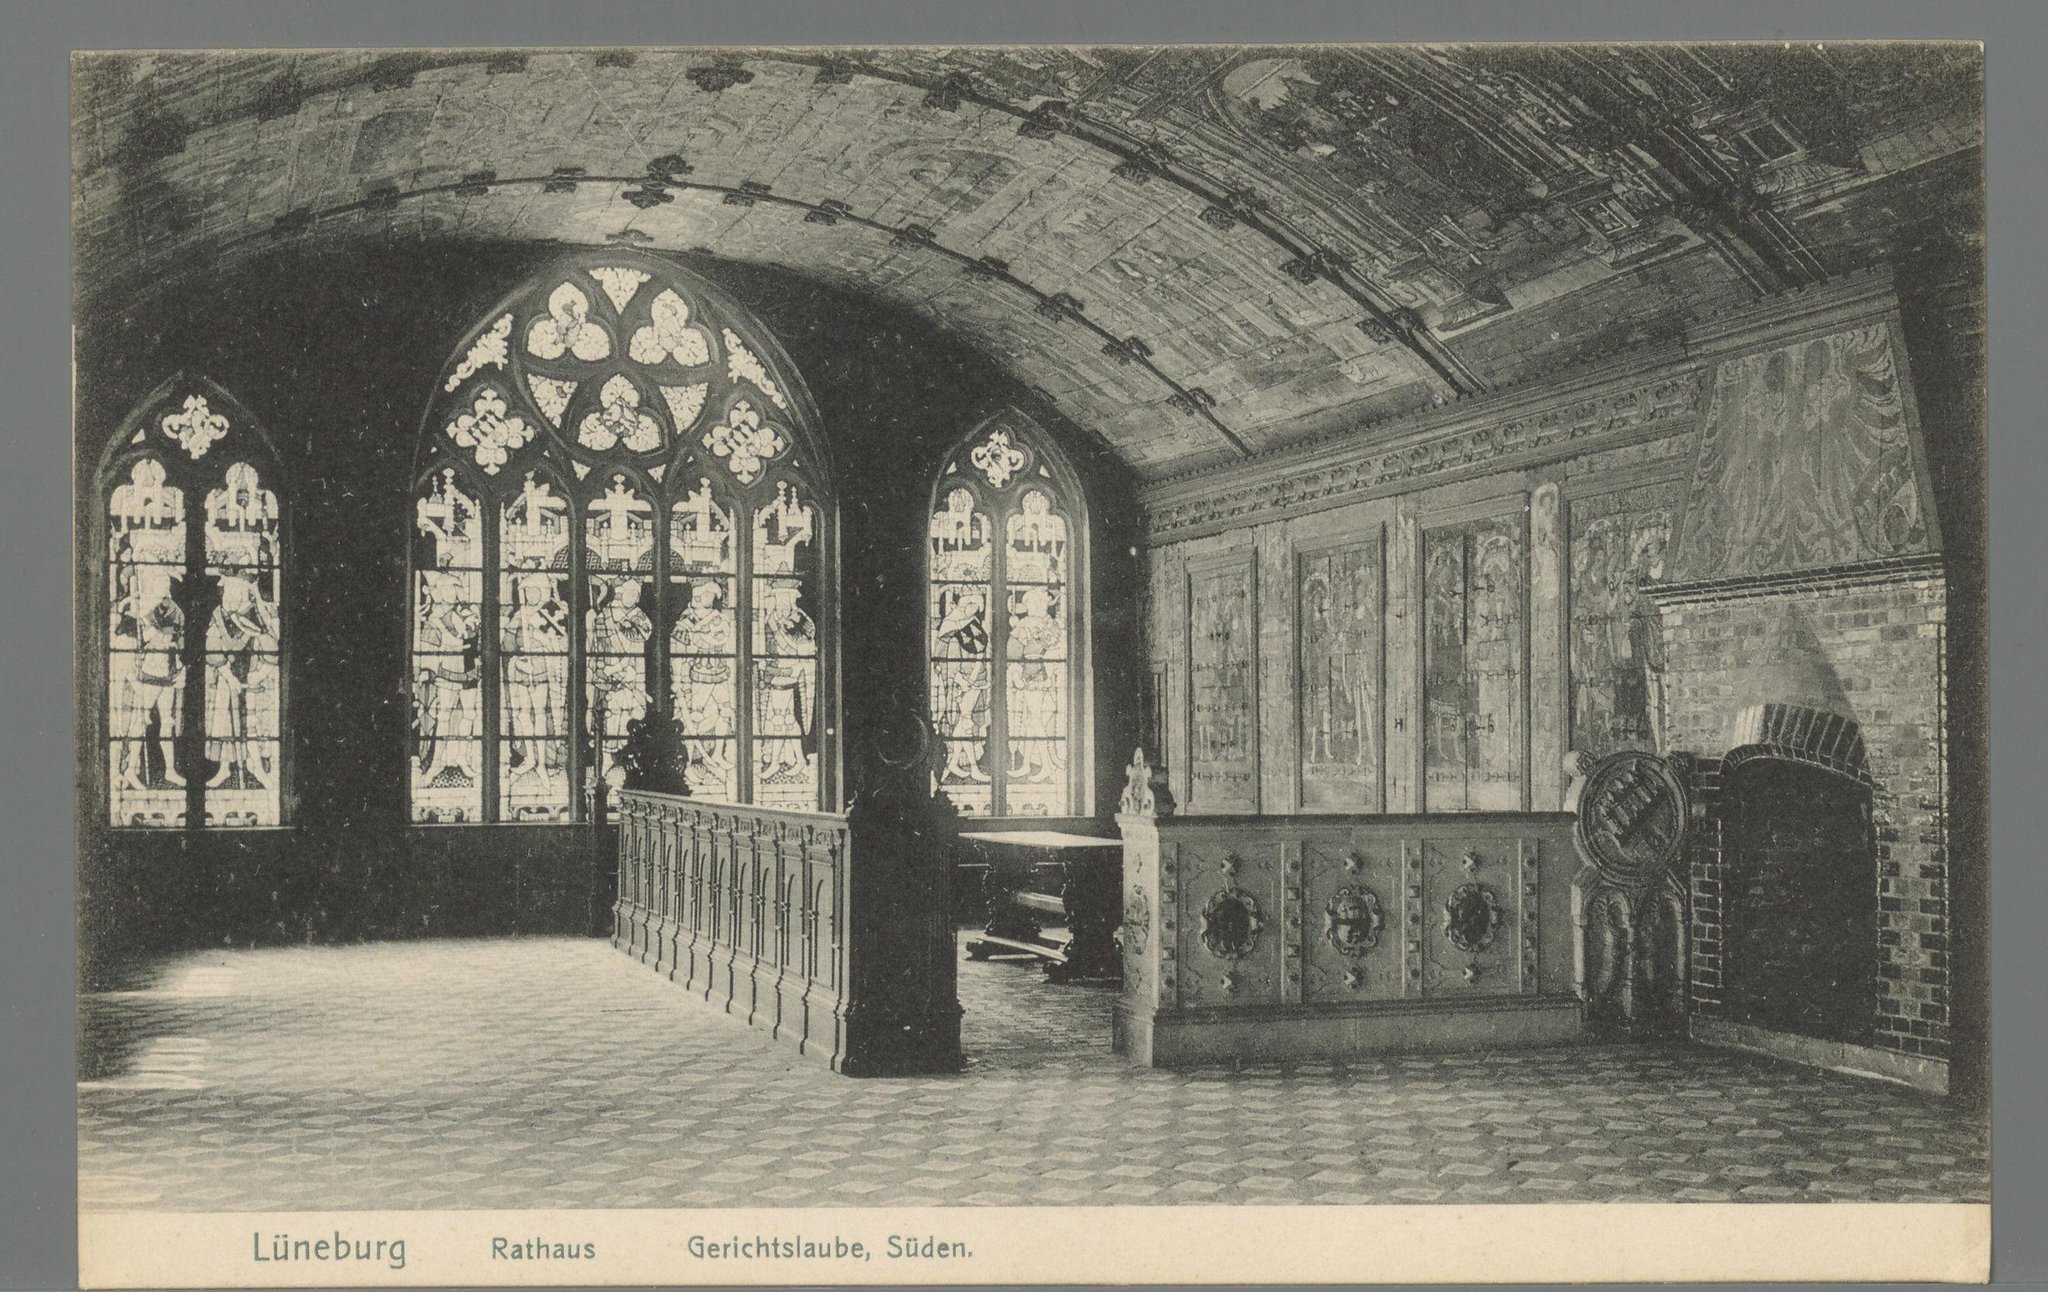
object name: photomechanical print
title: Lüneburg. Rathaus. Gerichtslaube, Süden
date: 1905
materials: cardboard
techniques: photograph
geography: hamburg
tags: townhall, interior of the house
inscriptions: date